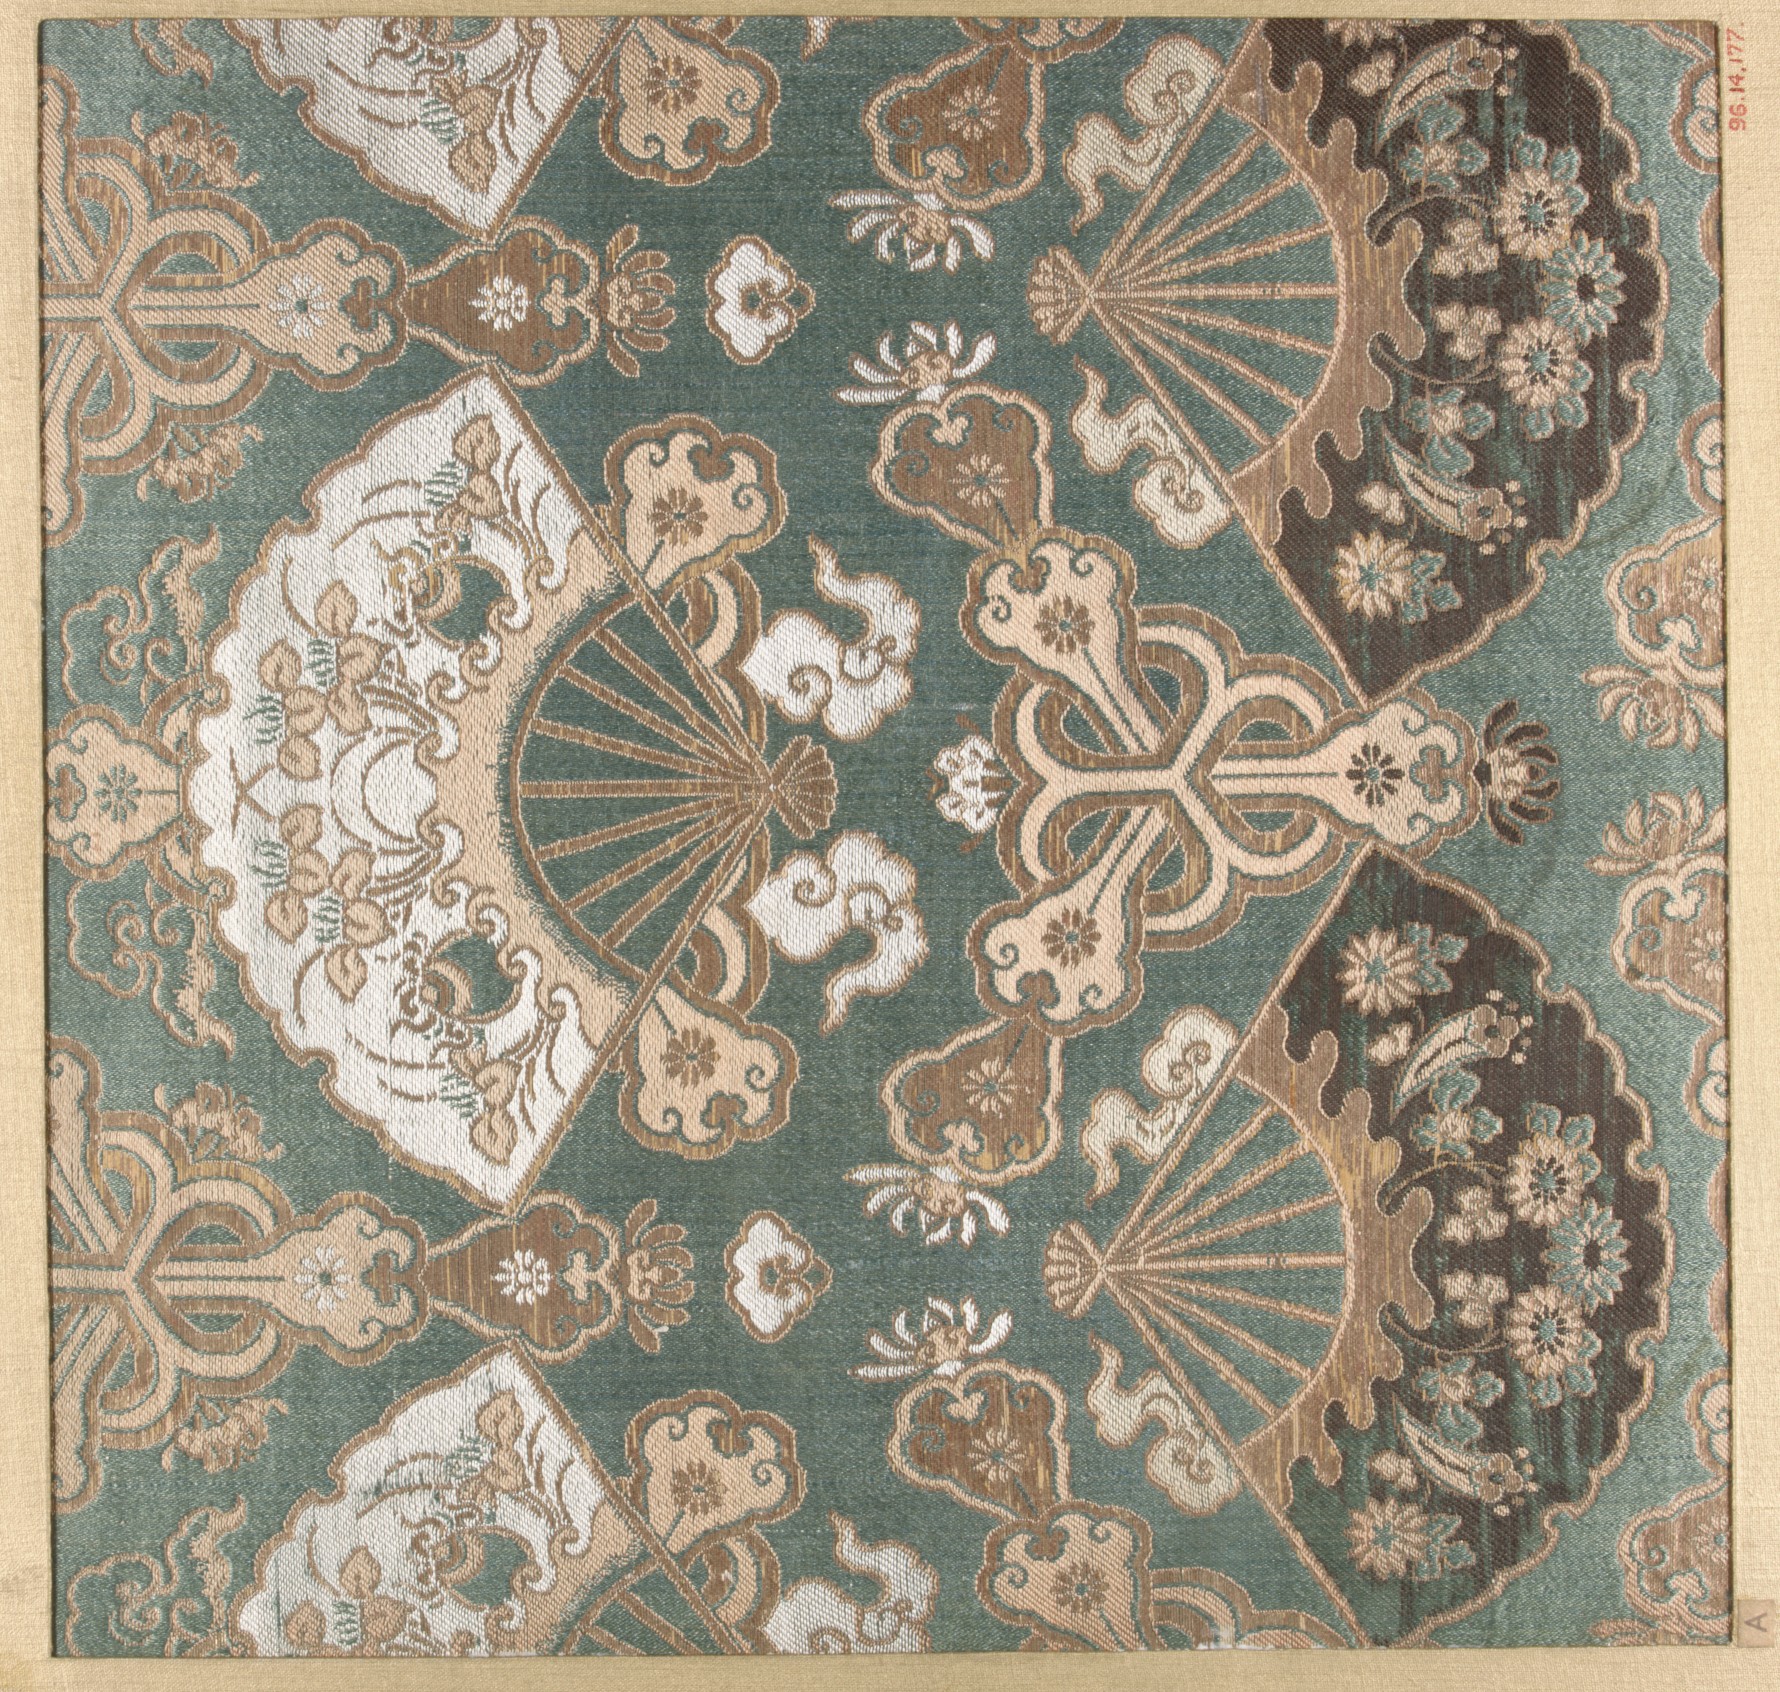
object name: piece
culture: japanese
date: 1701-1900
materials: silk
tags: flowers